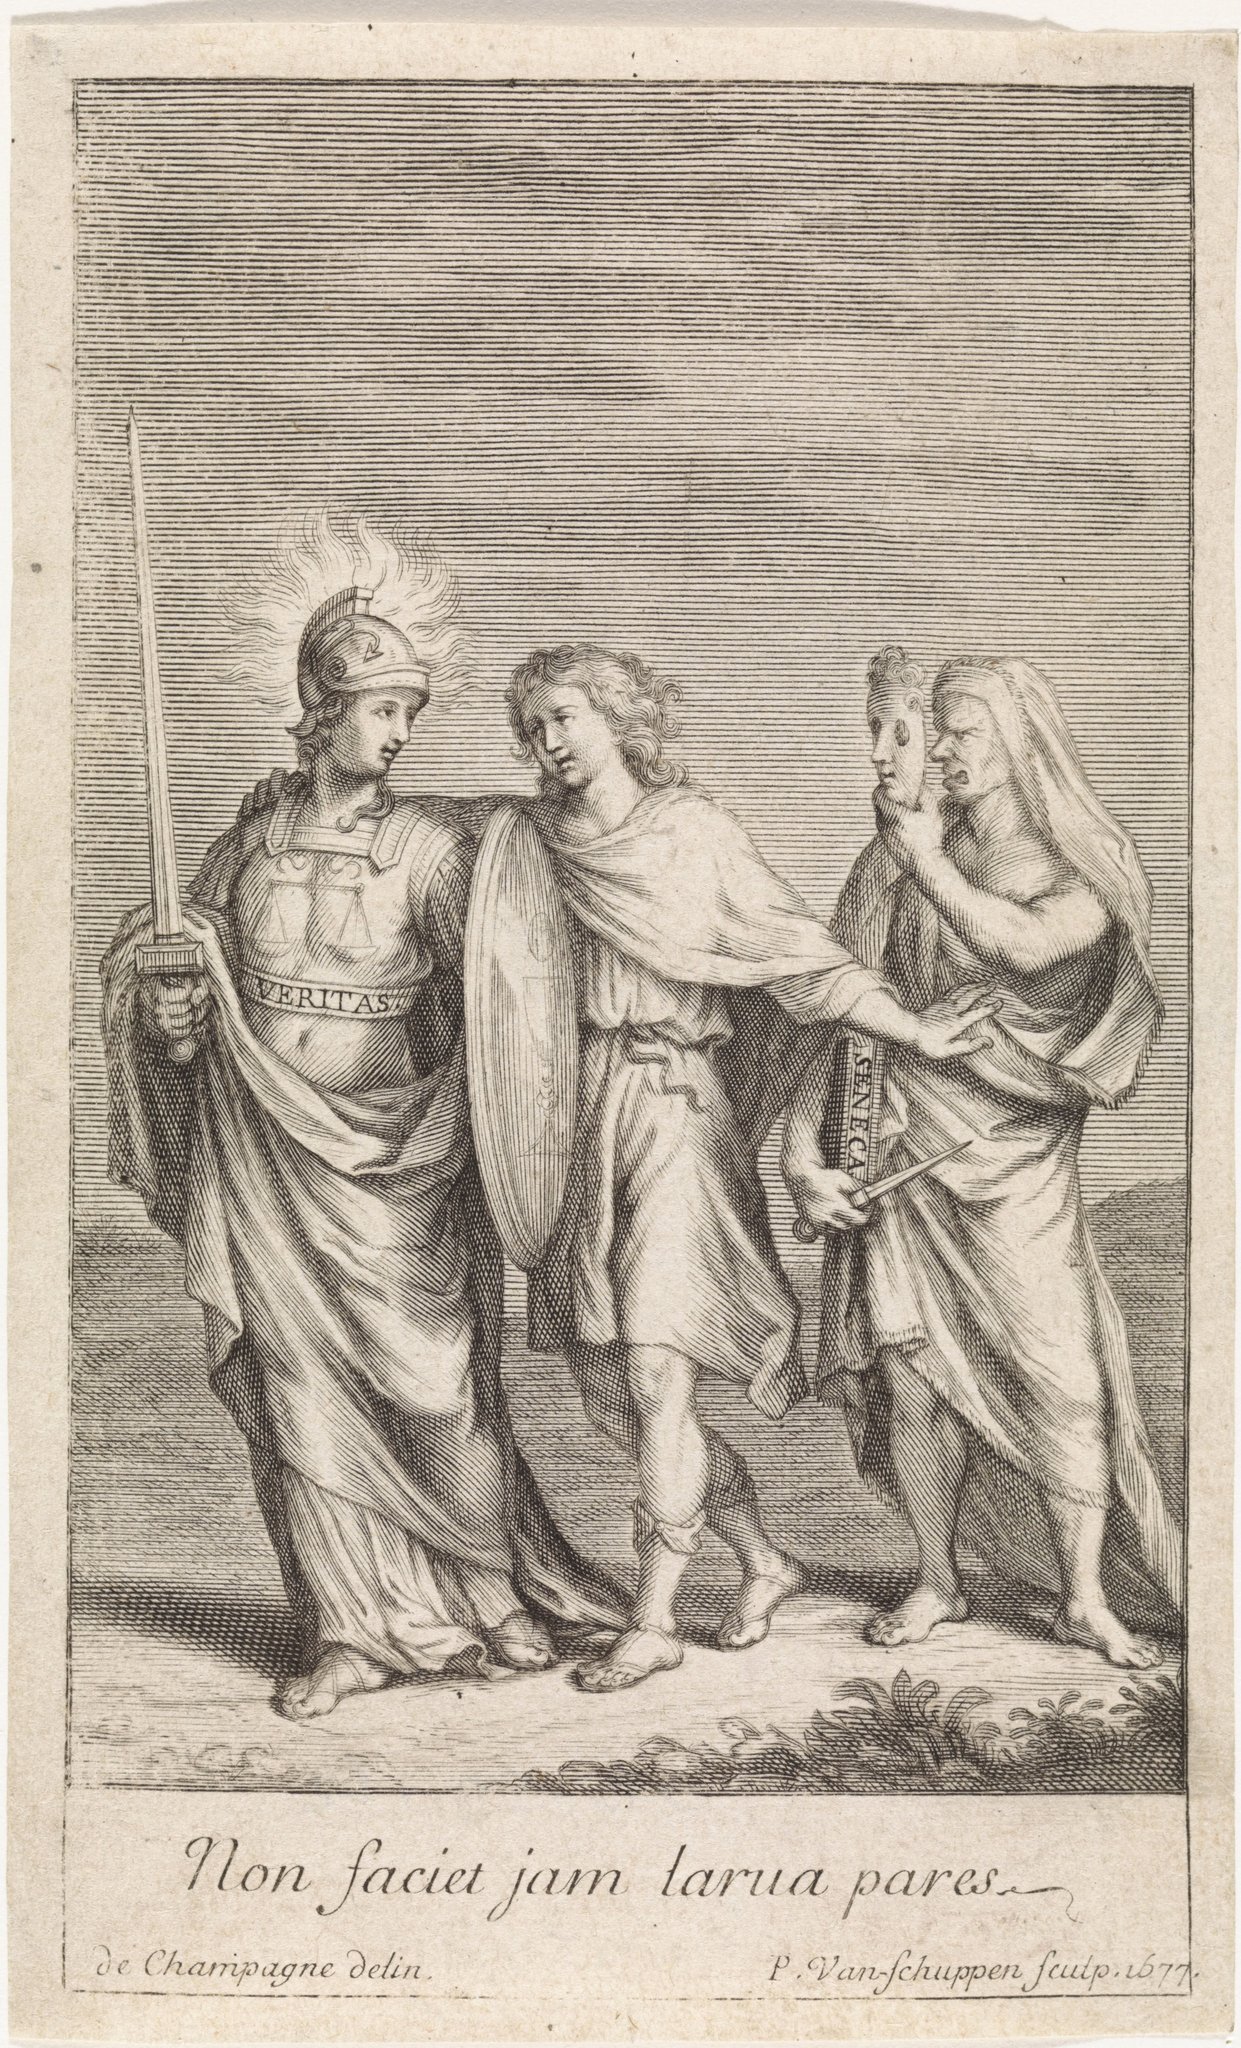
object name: print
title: Jongeman tussen Waarheid en Bedrog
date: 1677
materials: paper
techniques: engraving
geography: paris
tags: truth; 'verità' (ripa) (+ clothed), cheat, deceit; 'fraude', 'inganno' (ripa)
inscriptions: collector's mark: Lugt 240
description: Een jongeman in Romeinse kledij loopt tussen Veritas en een man, die een masker voorhoudt en een dolk in zijn hand heeft. Onder zijn arm draagt hij een boek met het opschrift 'Seneca'. In de marge een regel tekst in het Latijn.